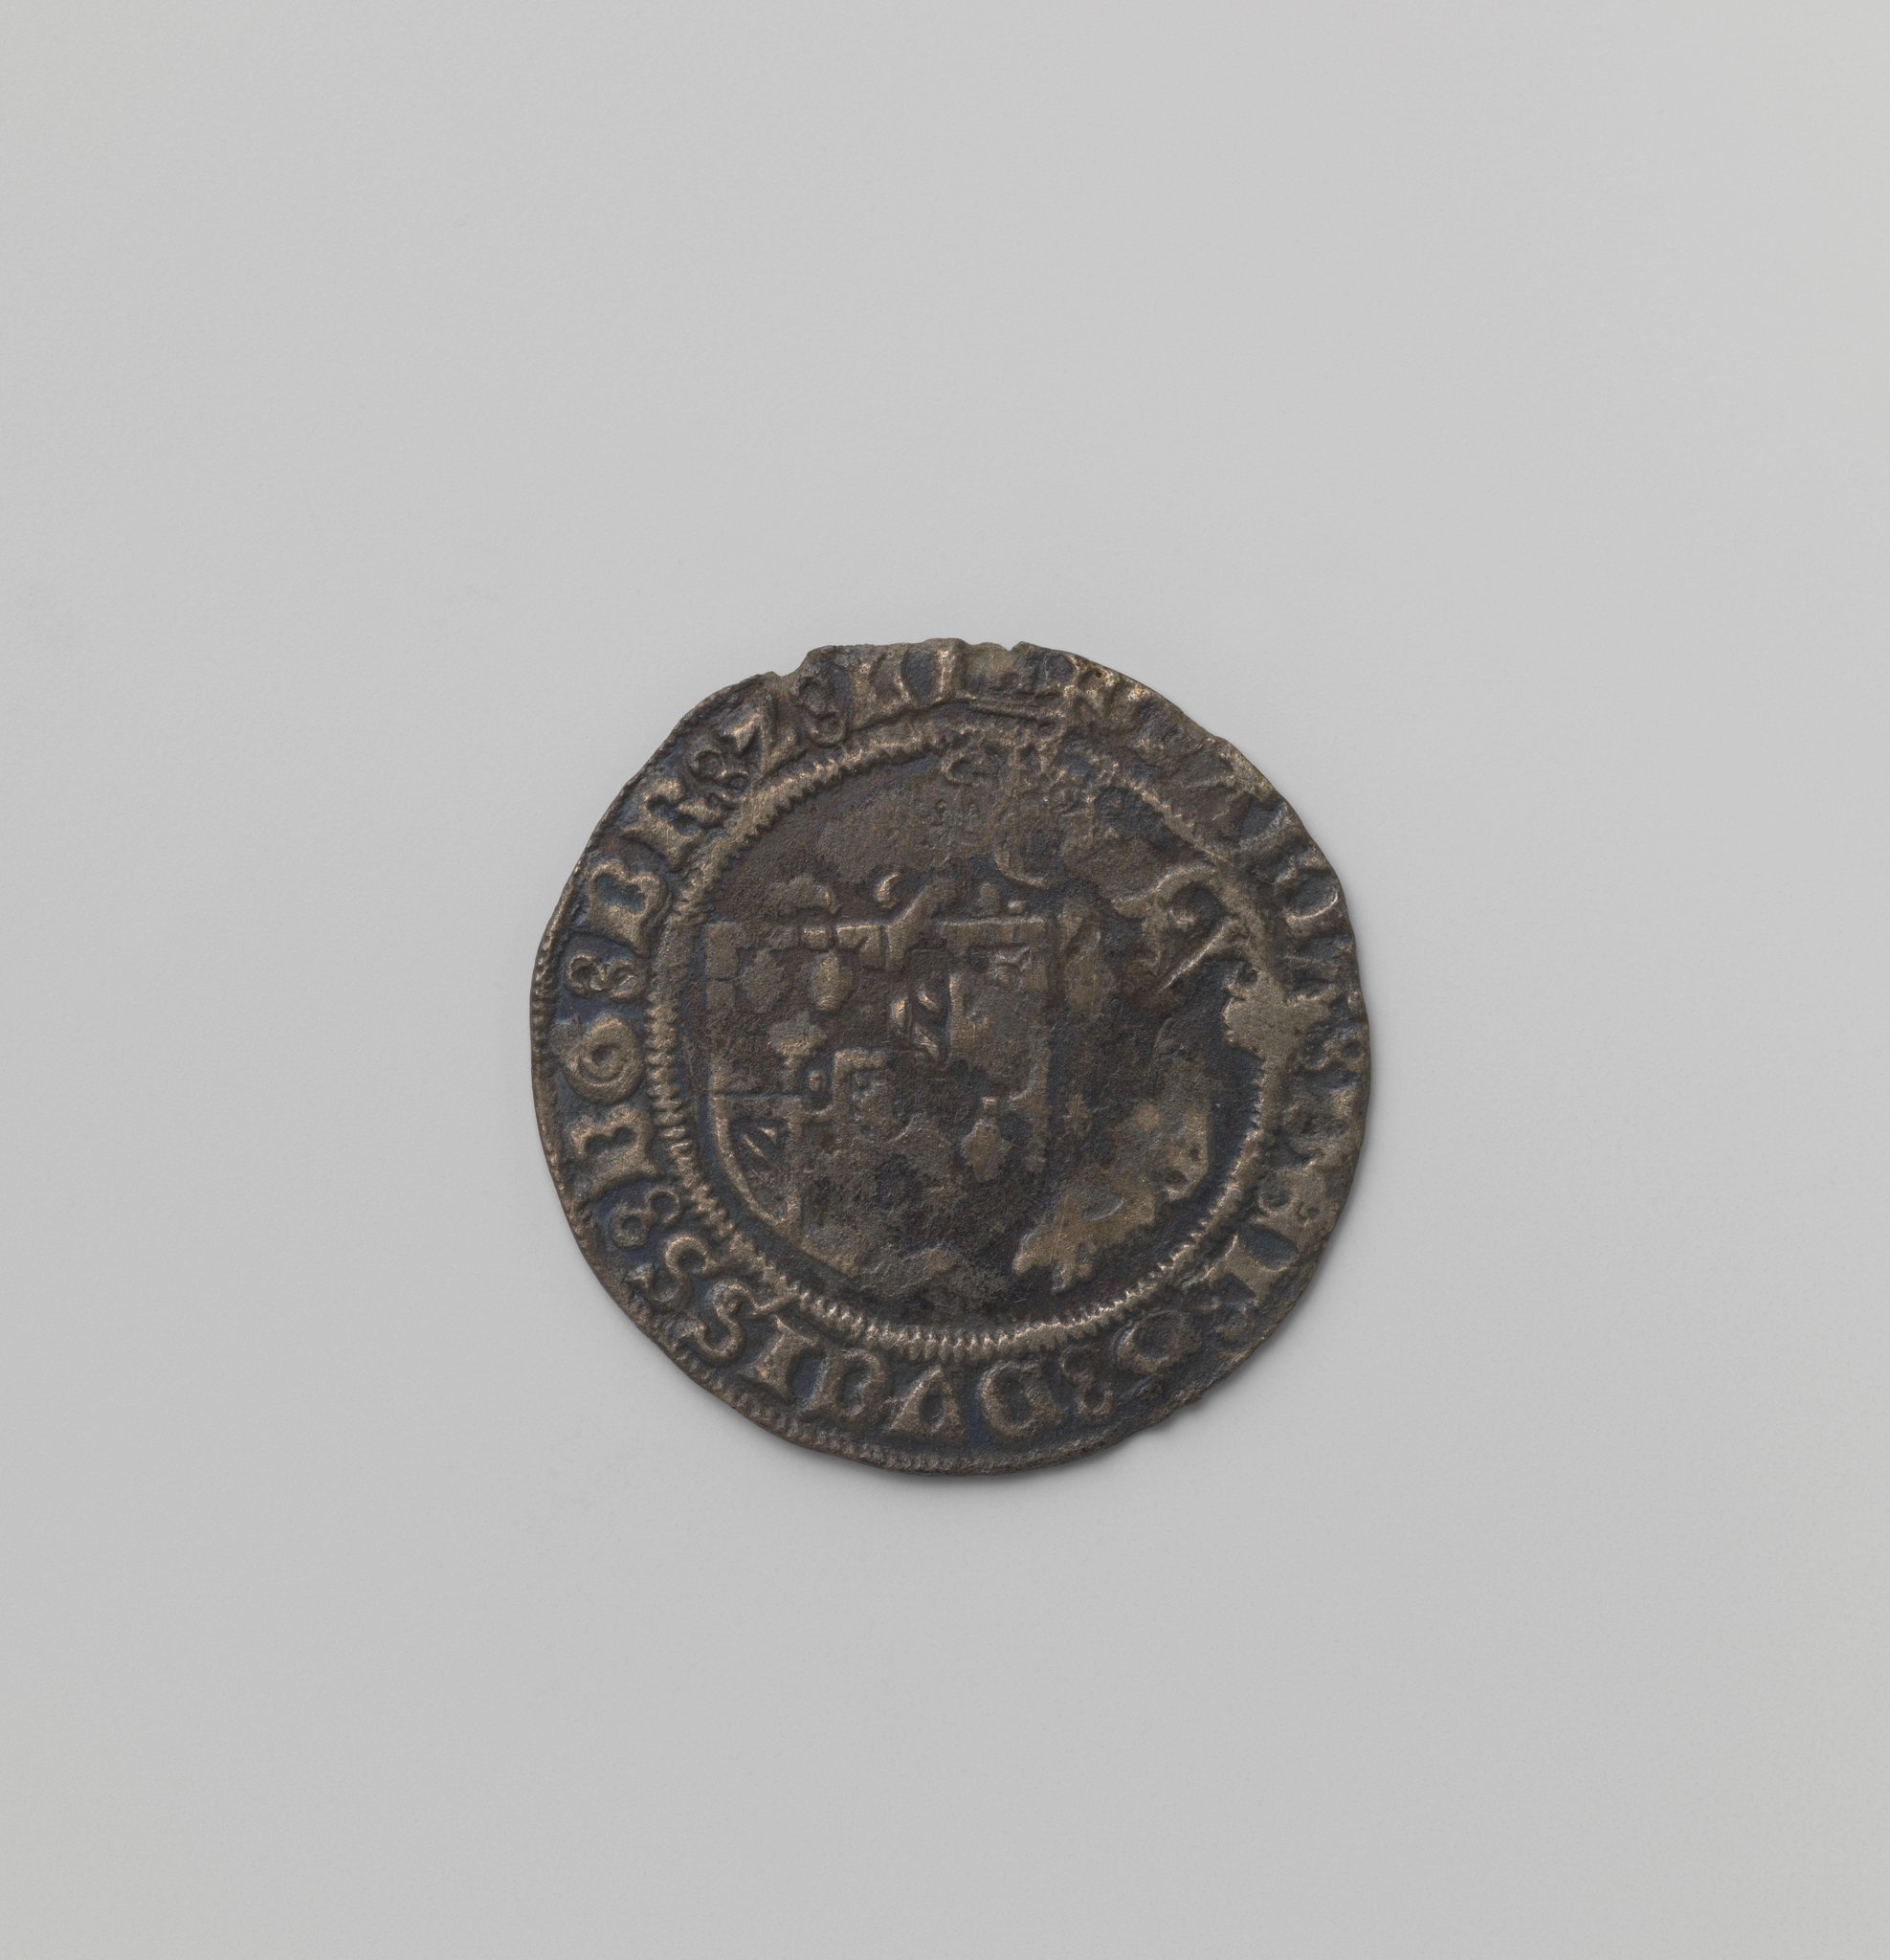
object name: coin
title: Brabant, Maria van Bourgondië, vuurijzer, 1479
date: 1479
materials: silver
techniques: striking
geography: antwerp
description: Zilveren munt. Voorzijde: zittende leeuw naar links met voor zich wapenschild. Daarboven vuurijzer. Toren aan het eind van het omschrift. Keerzijde: kort gebloemd kruis. Jaartal in omschrift.